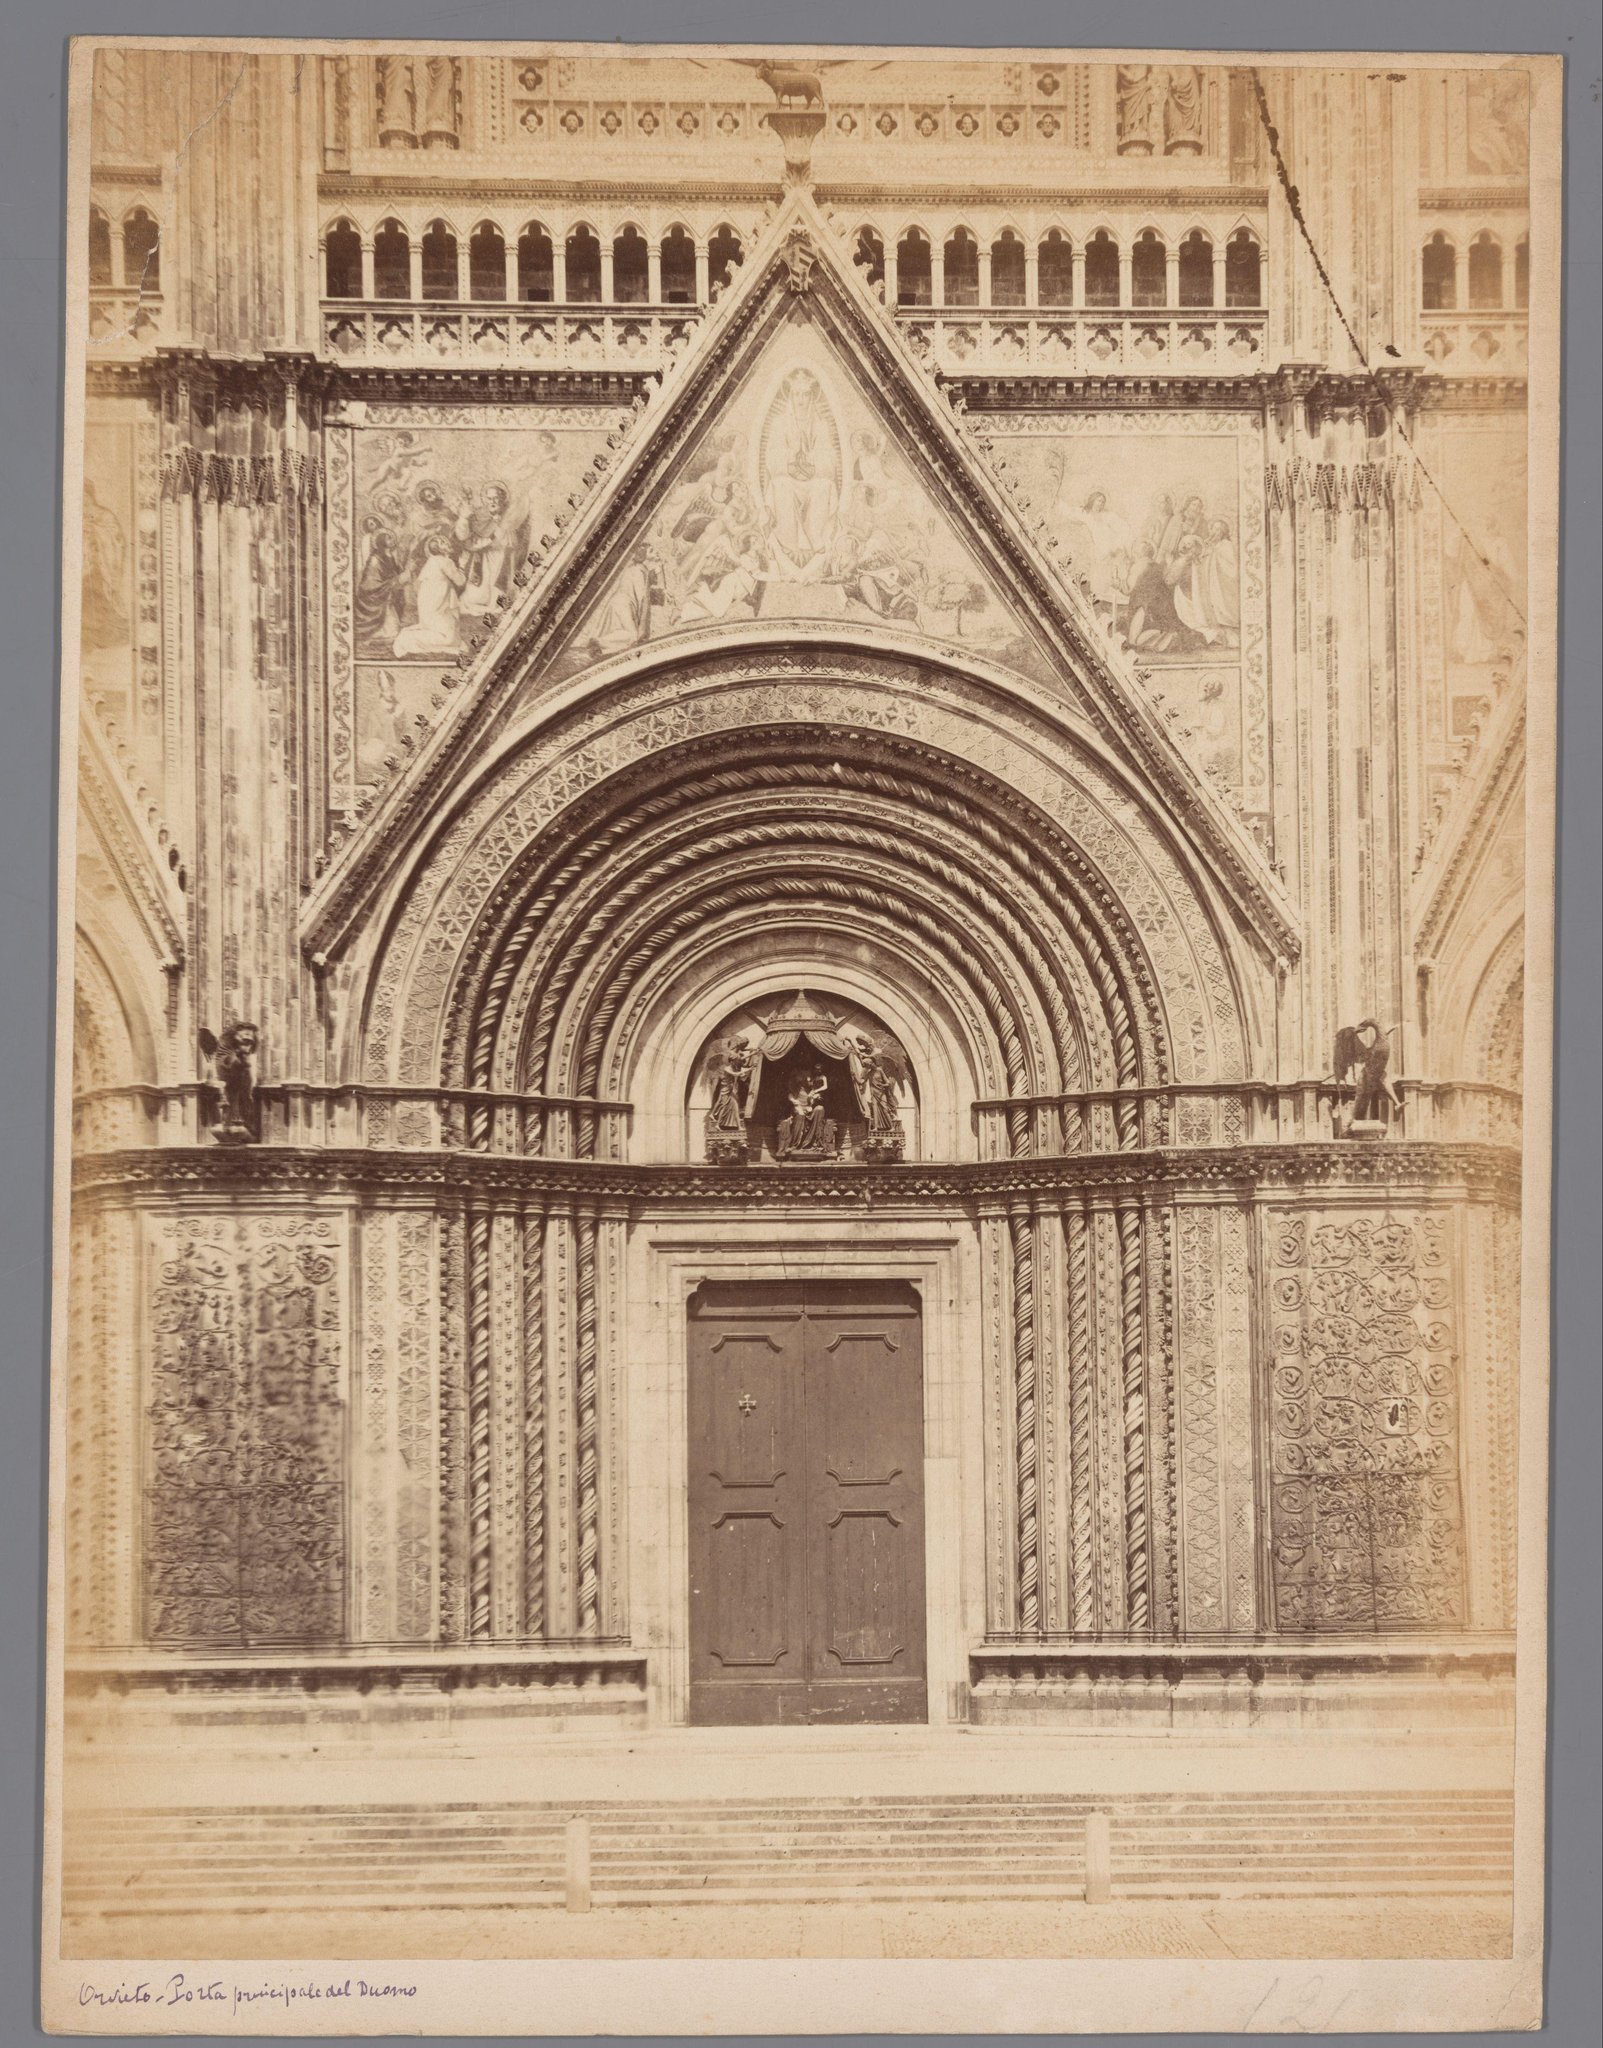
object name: photograph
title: Orvieto - Porta principale del Duomo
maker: Anonymous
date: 1851-1900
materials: cardboard, paper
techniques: albumen print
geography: orvieto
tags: parts of church exterior and annexes: portal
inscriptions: inscription: ‘121’